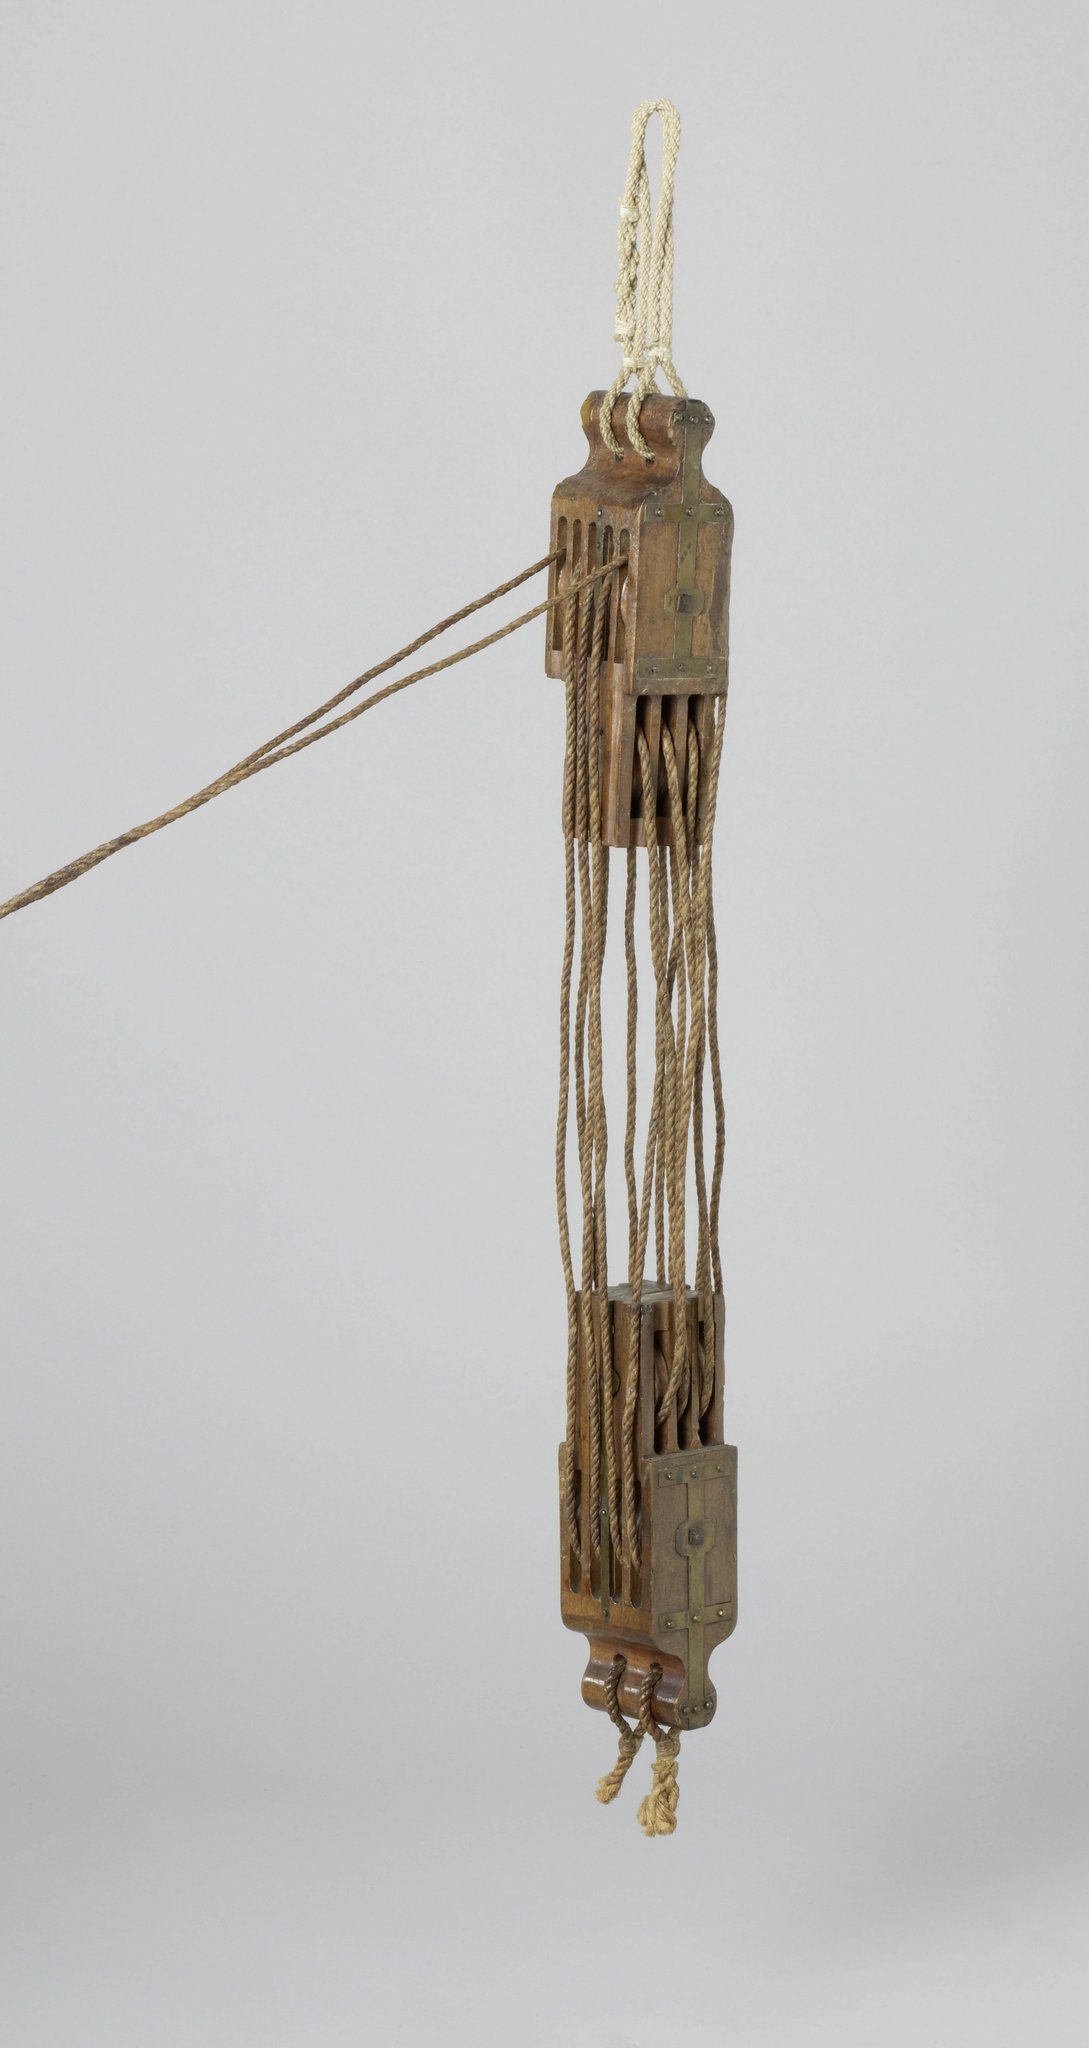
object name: demonstration model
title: Model of a Jeer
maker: Anonymous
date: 1820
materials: brass, fiber, wood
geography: netherlands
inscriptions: label, tied to the rope: ‘590’ former inventory label, inscription, on the lower block: ‘LETTRA / C / N° 14’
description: Model van een gijn gestaande uit twee blokken. Ieder blok heeft twee rijen schijven die in een loodrecht vlak op elkaar staan; door het takel zijn de blokken zodanig verbonden dat buitenste en binnenste rijen schijven van het gijn parallel lopen. De buitenste rij schijven van het bovenste blok heeft vijf schijven, de binnenste rij drie, de binnenste rij van het onderste blok drie en de buitenste rij vier. Het takel loopt door de bovenste rij van het bovenste blok naar de binnenste rij van het onderste blok, van daar heen en weer tussen de twee binnenste rijen, verder naar de onderste rij van het onderste blok en ten slotte heen en weer tussen de twee buitenste rijen van de blokken. Dubbelgijnen van dit type werden bij molens gebruikt.